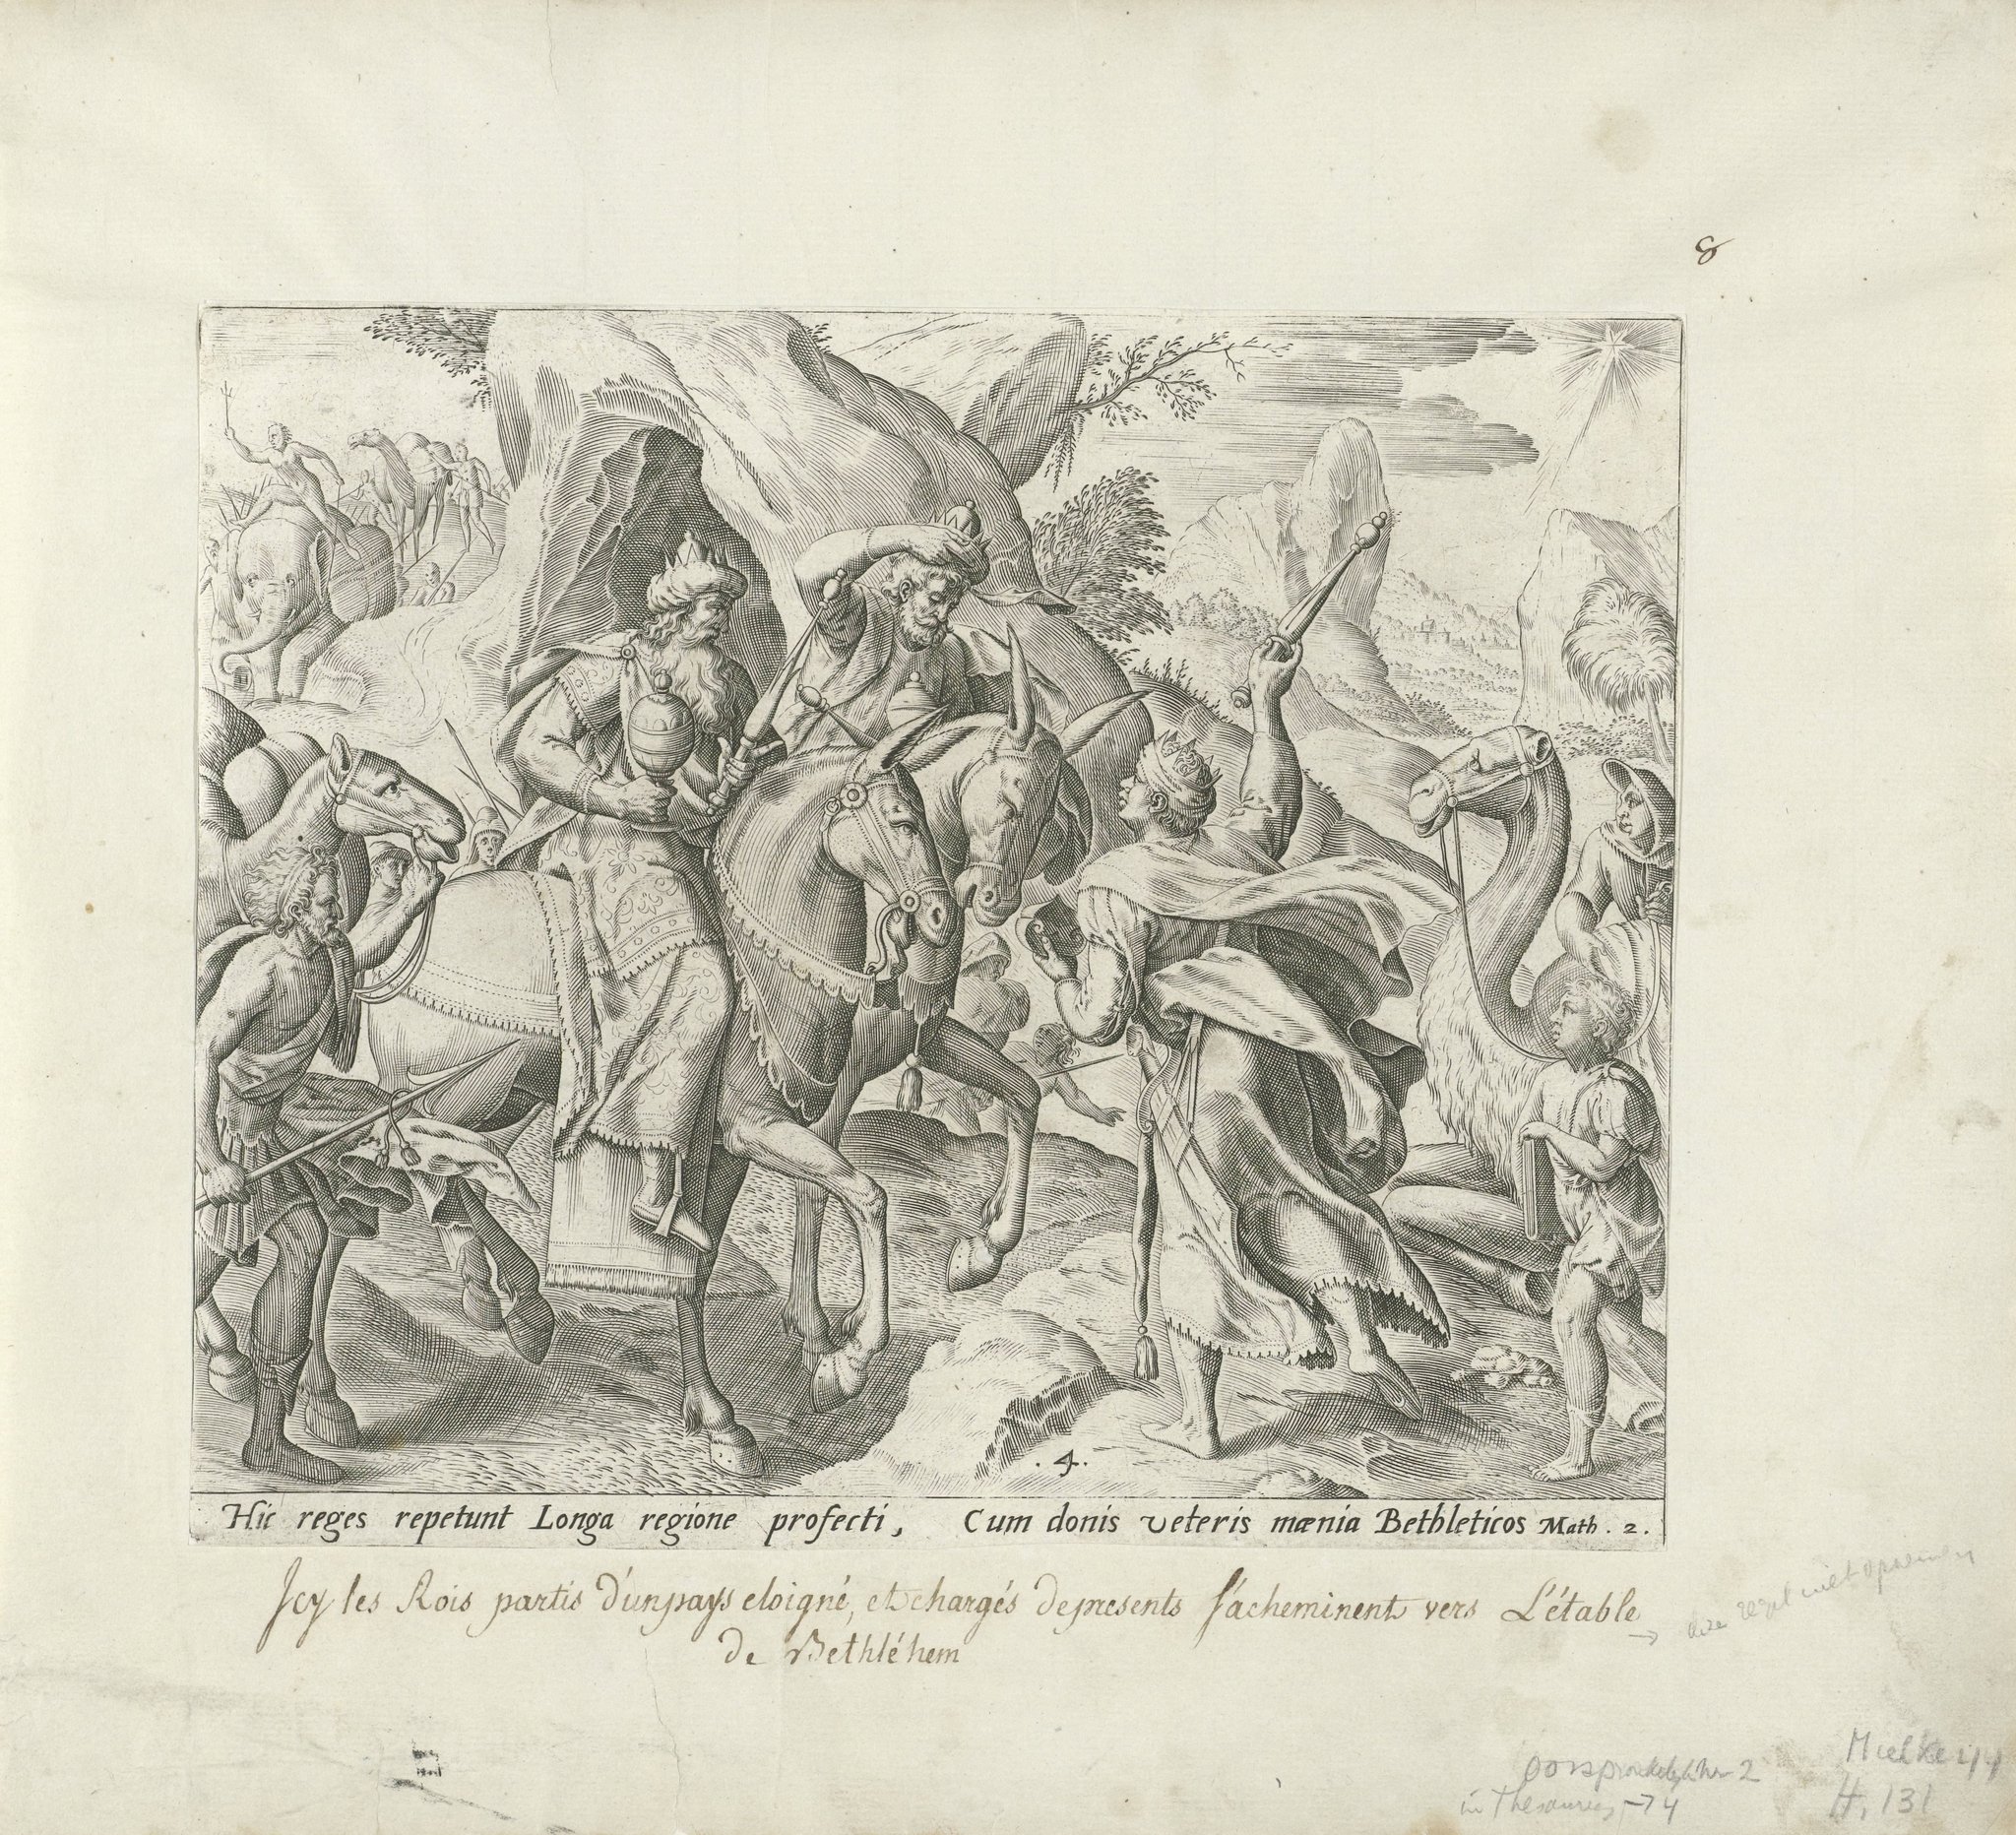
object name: print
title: Geboorte van Christus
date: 1585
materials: paper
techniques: engraving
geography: antwerp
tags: the three wise men meet at the crossroads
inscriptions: collector's mark: Lugt 2228, number: ‘8’, caption: ‘Joy les Rois partis d'unpays eloigné et chargés depresents f'acheminents vers l'etable de Bethélhem’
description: De drie koningen ontmoeten elkaar op de weg naar Bethlehem. Een van hen wijst met zijn staf naar de ster die ze moeten volgen. De prent heeft een Latijns onderschrift met een Bijbeltekst.